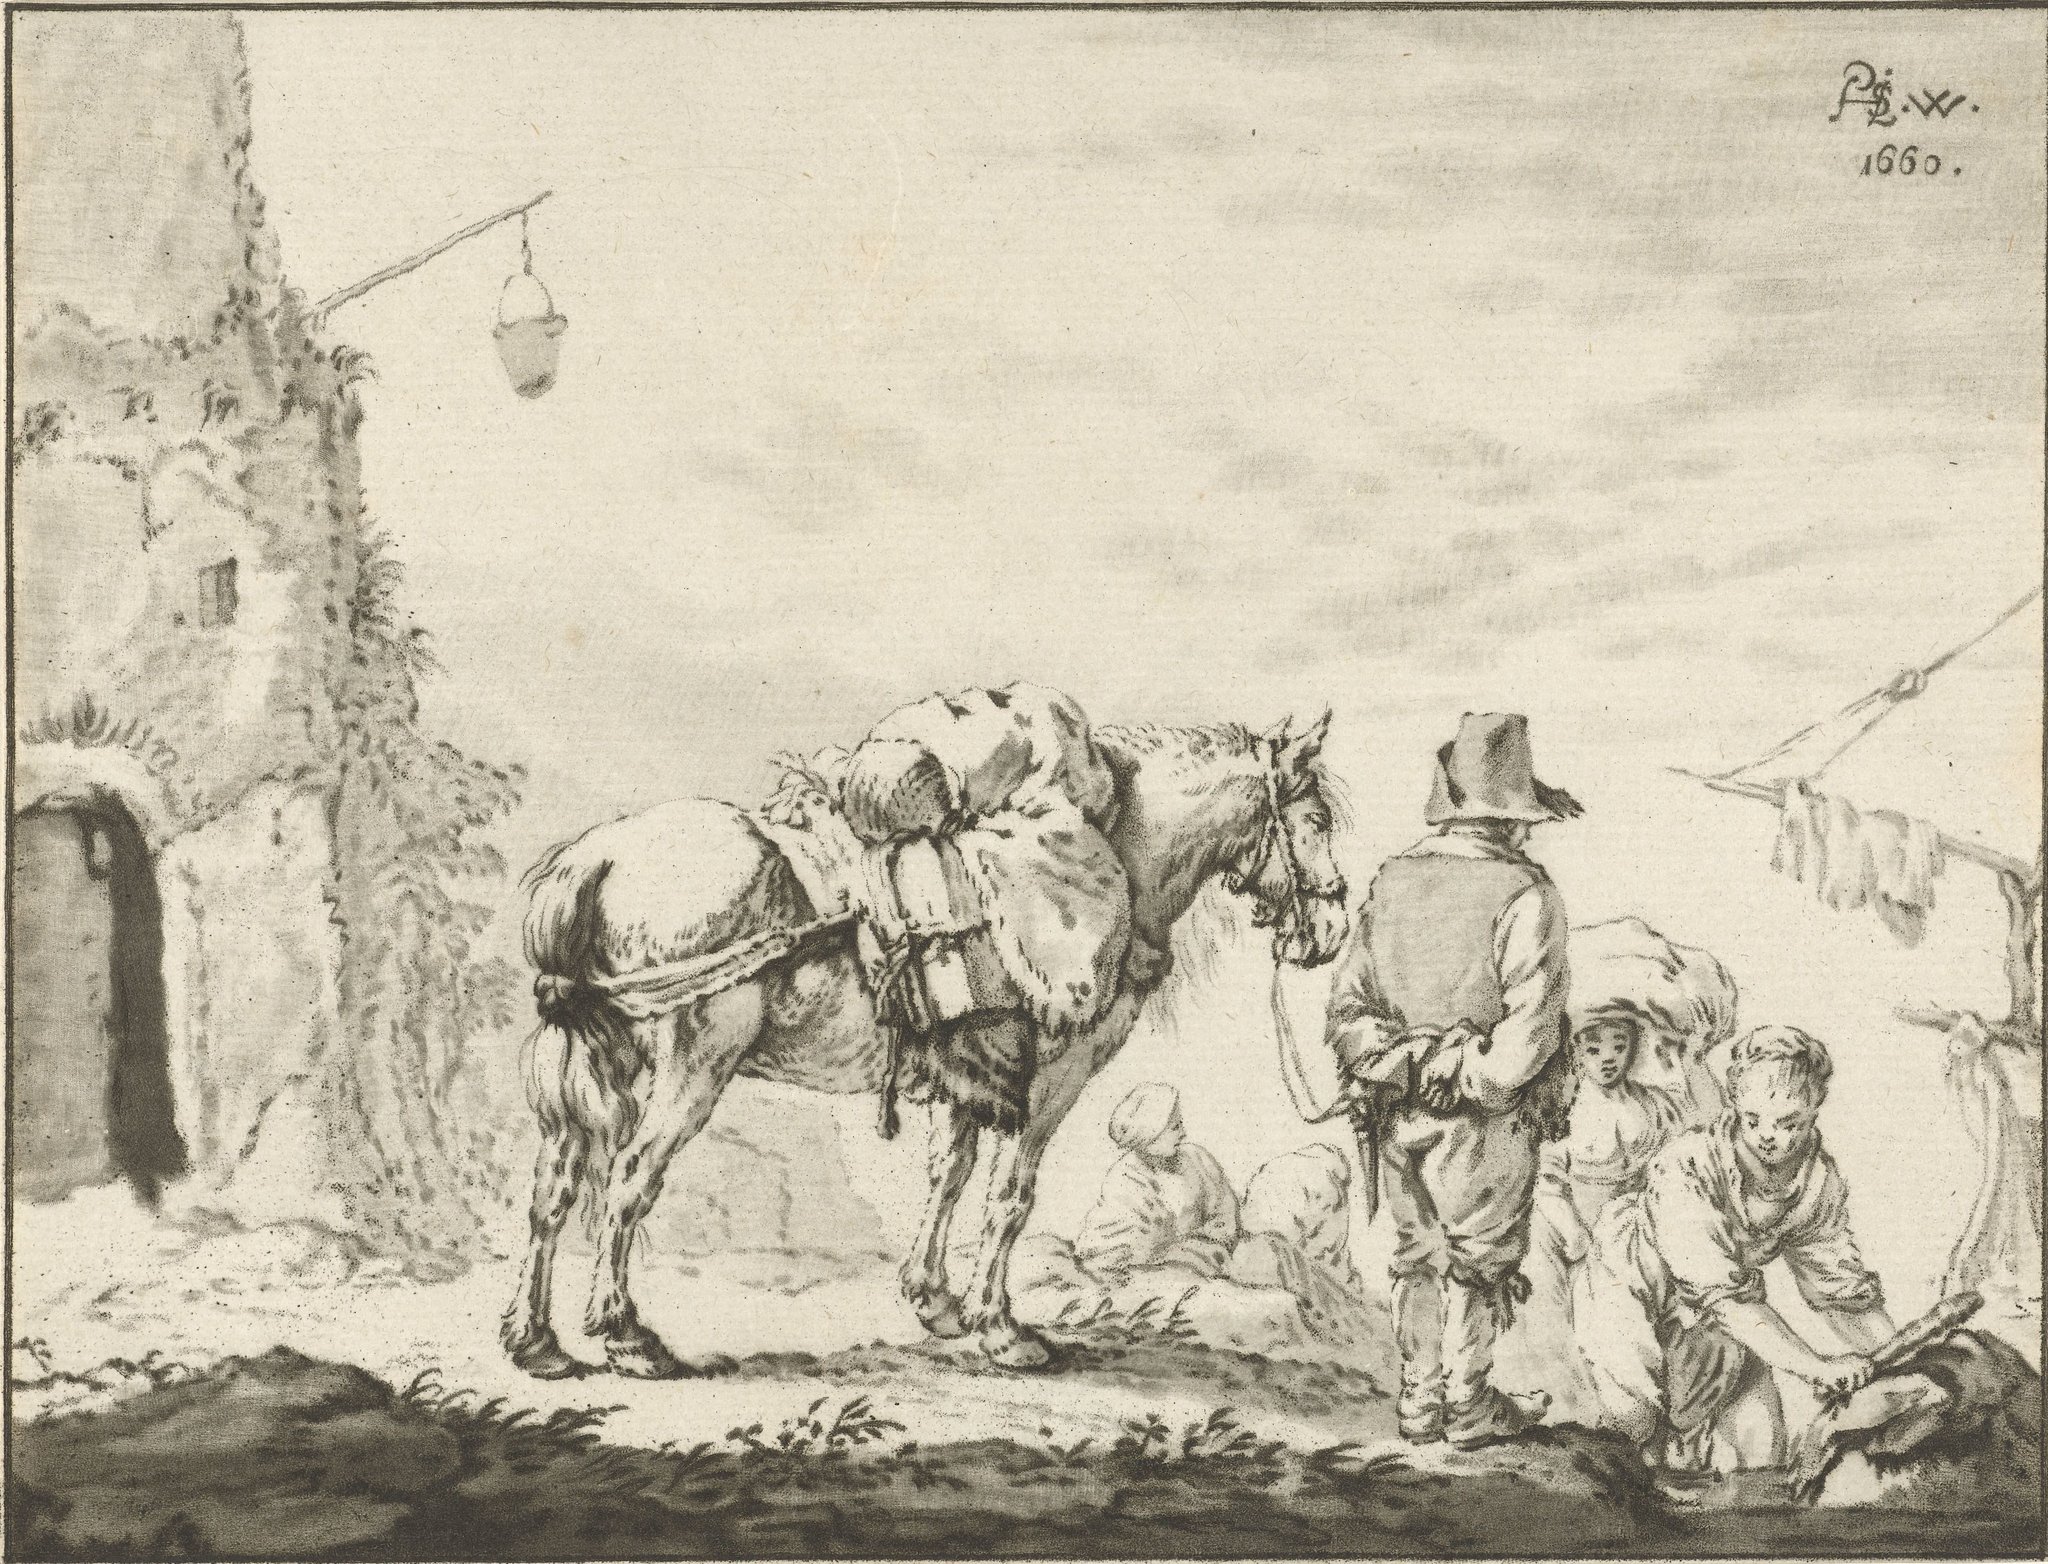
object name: print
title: Man met paard bij wasvrouw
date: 1772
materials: paper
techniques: printmaking, roulette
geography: amsterdam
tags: laundering, horse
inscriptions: collector's mark: Lugt 2228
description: Een man, houdt de teugels van zijn paard vast, terwijl hij bij een vrouw staat die de was doet. Zij staat tot haar knieën in het water.